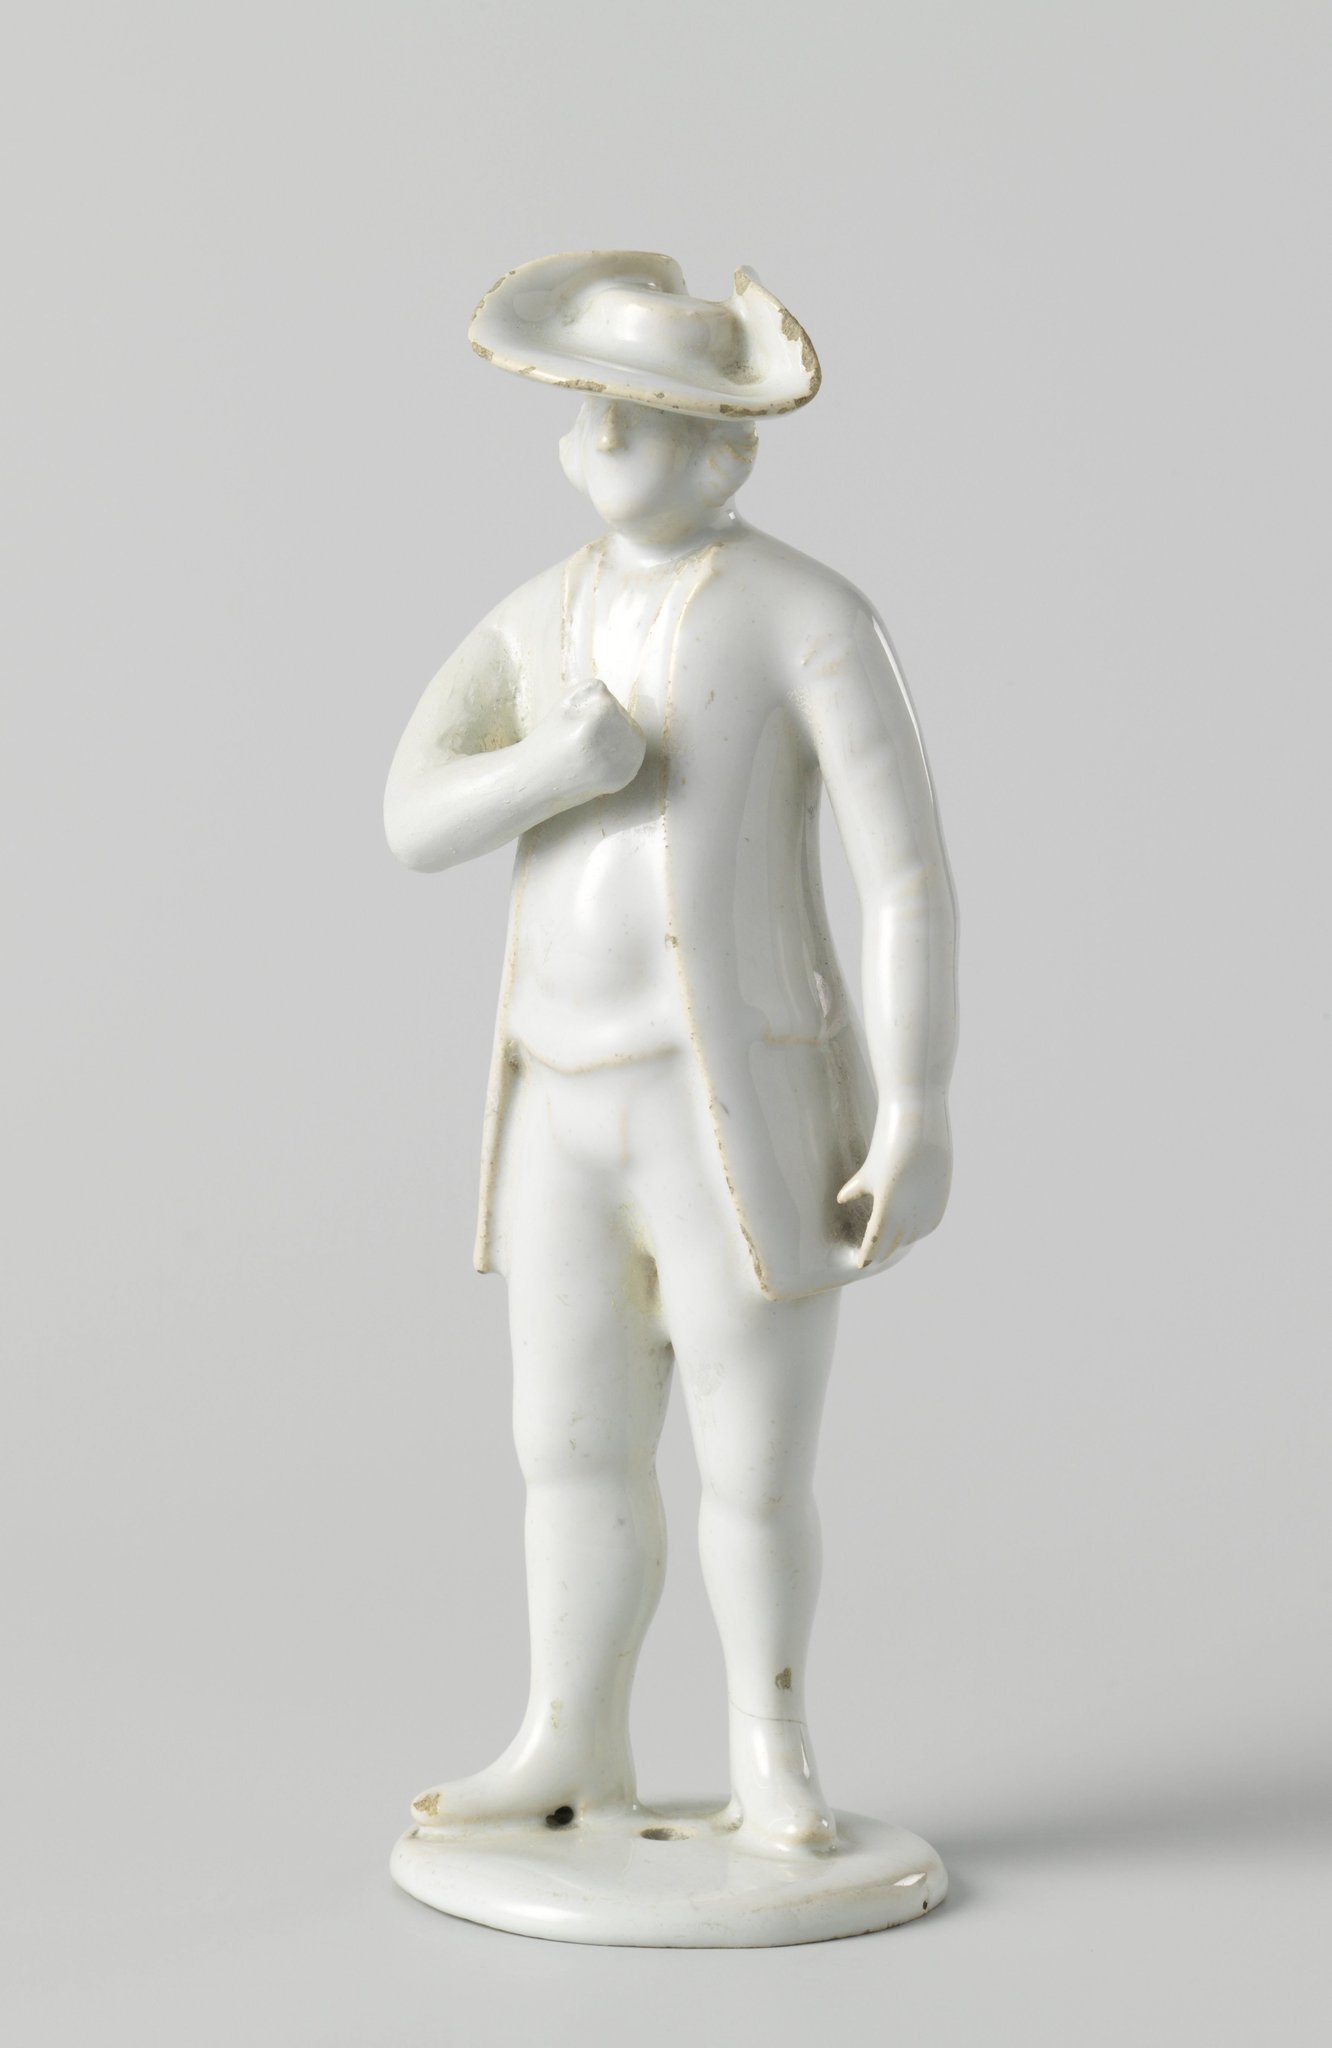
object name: decoratief object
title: Mannenfiguur met steek op zijn hoofd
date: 1770-1800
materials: earthenware, glaze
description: Beeld van ongedecoreerde faience. Op een rond voetstuk staat een man. De man draagt een steek op zijn hoofd en heeft zijn rechterarm op zijn borst, zijn linkerarm hangt naast zijn lichaam.